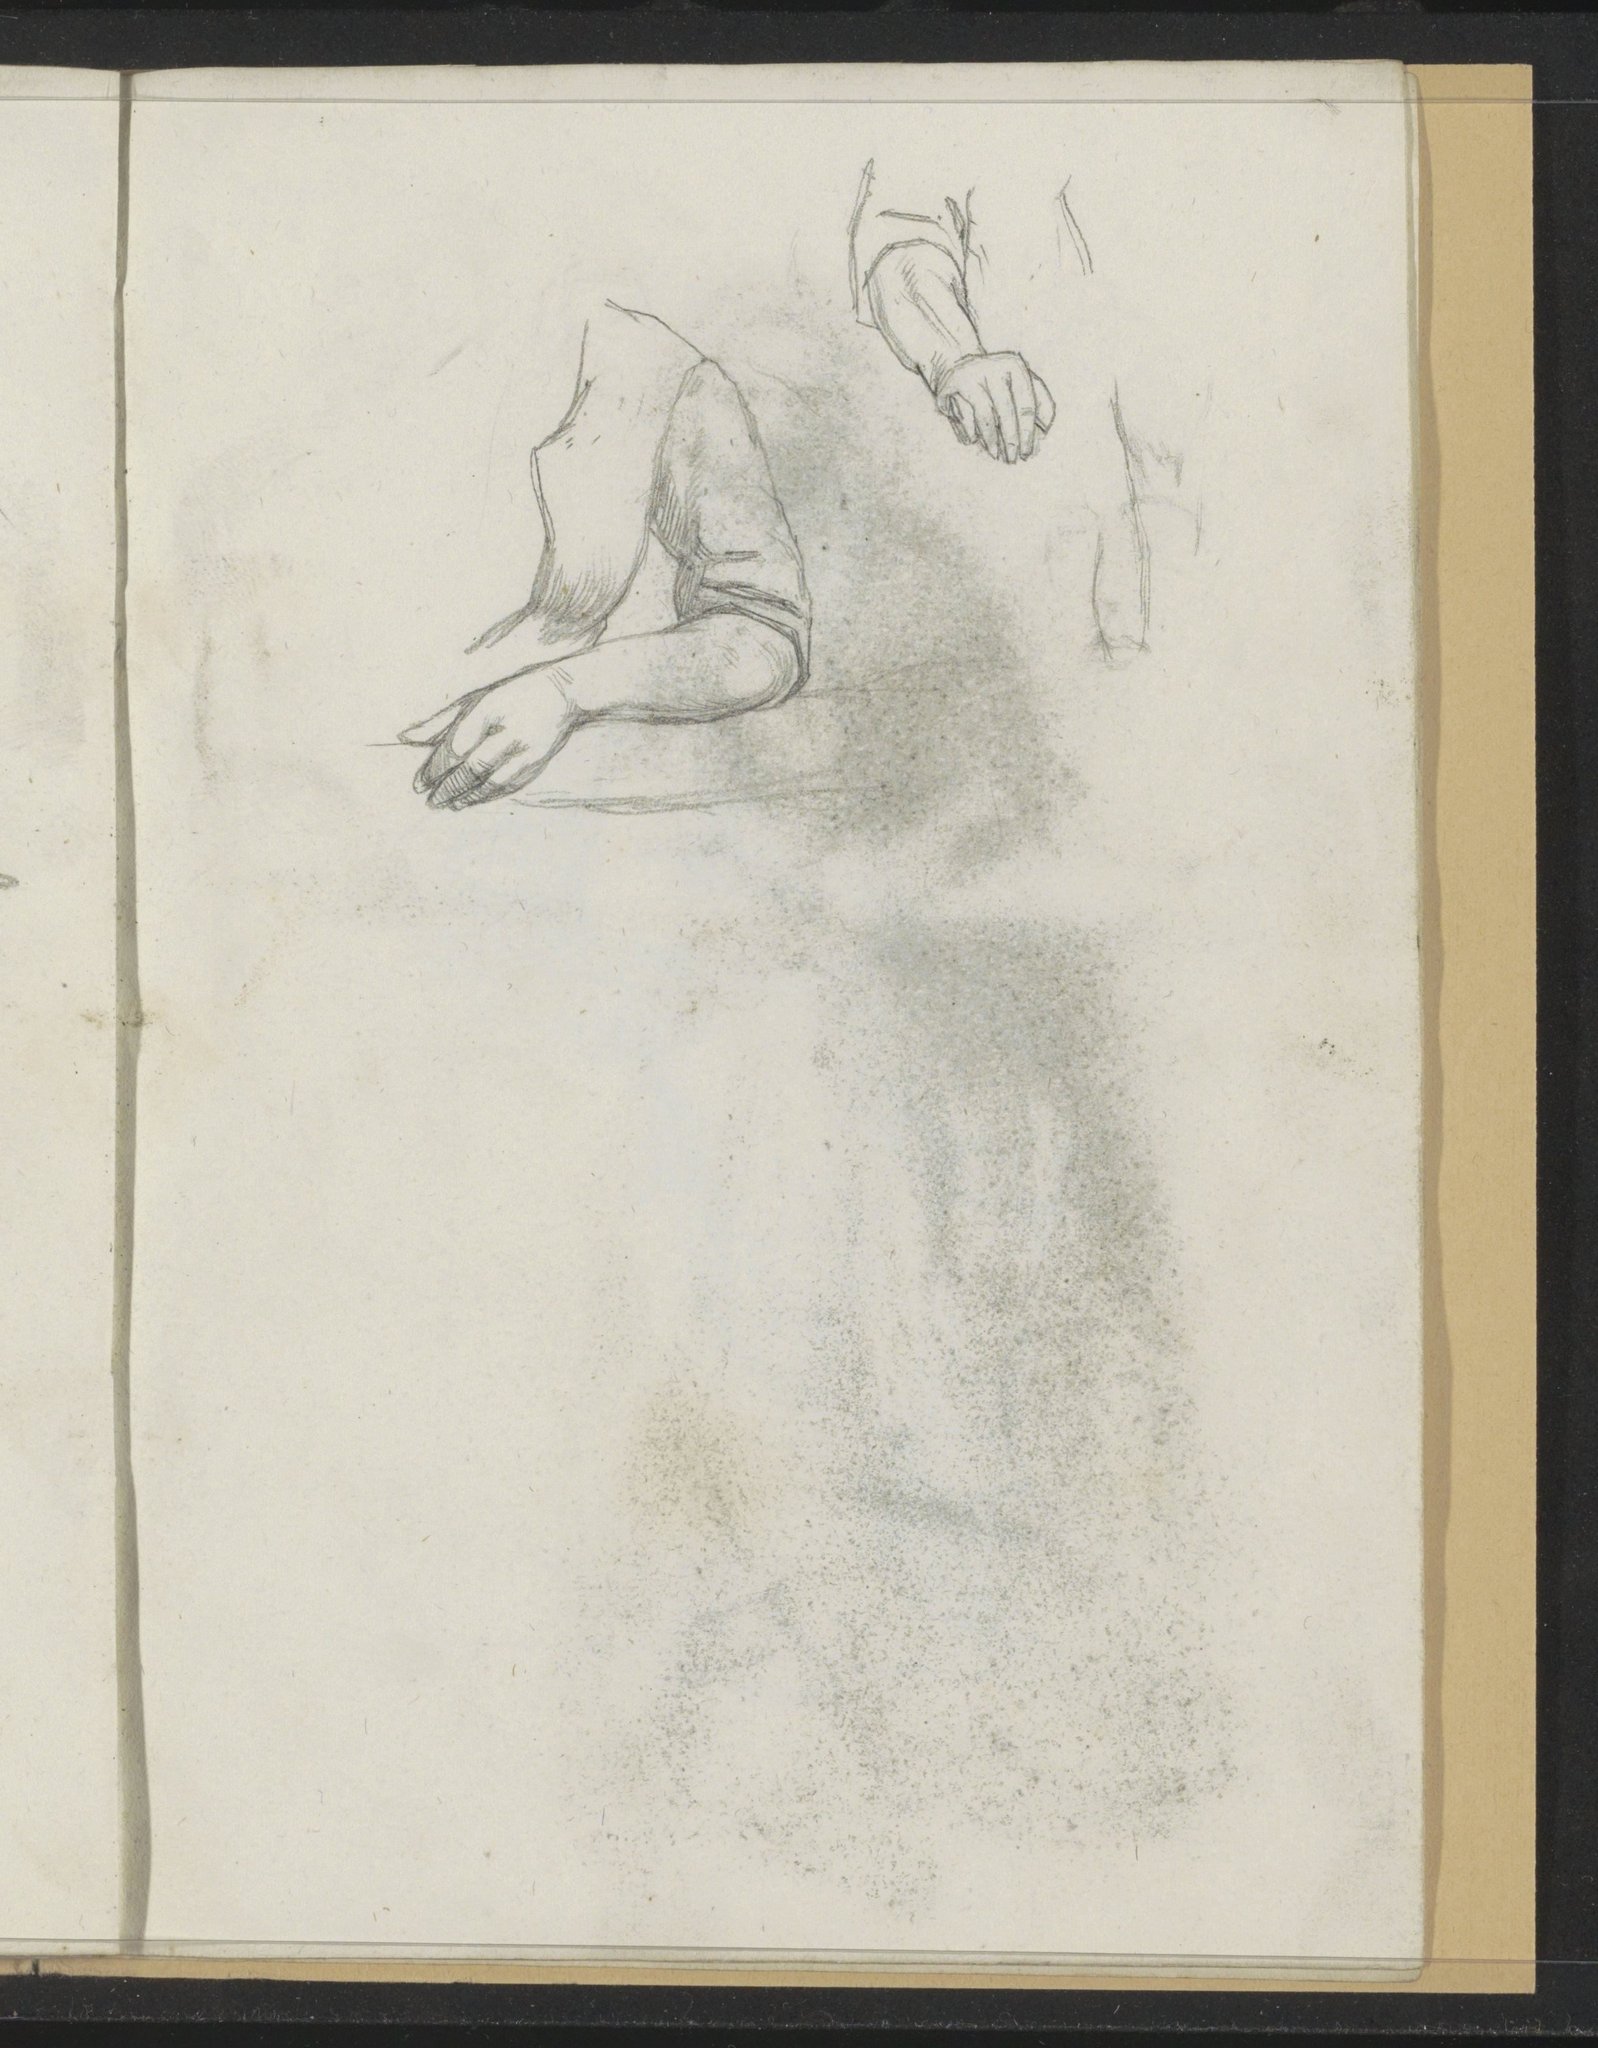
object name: sketchbook leaf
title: Armen, waarvan één arm leunend op een balk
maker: jozef israëls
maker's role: draughtsman, painter, print maker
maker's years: 1824-1911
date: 1834-1911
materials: paper, pencil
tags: arms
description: Blad 14 recto uit een schetsboek met 16 bladen.